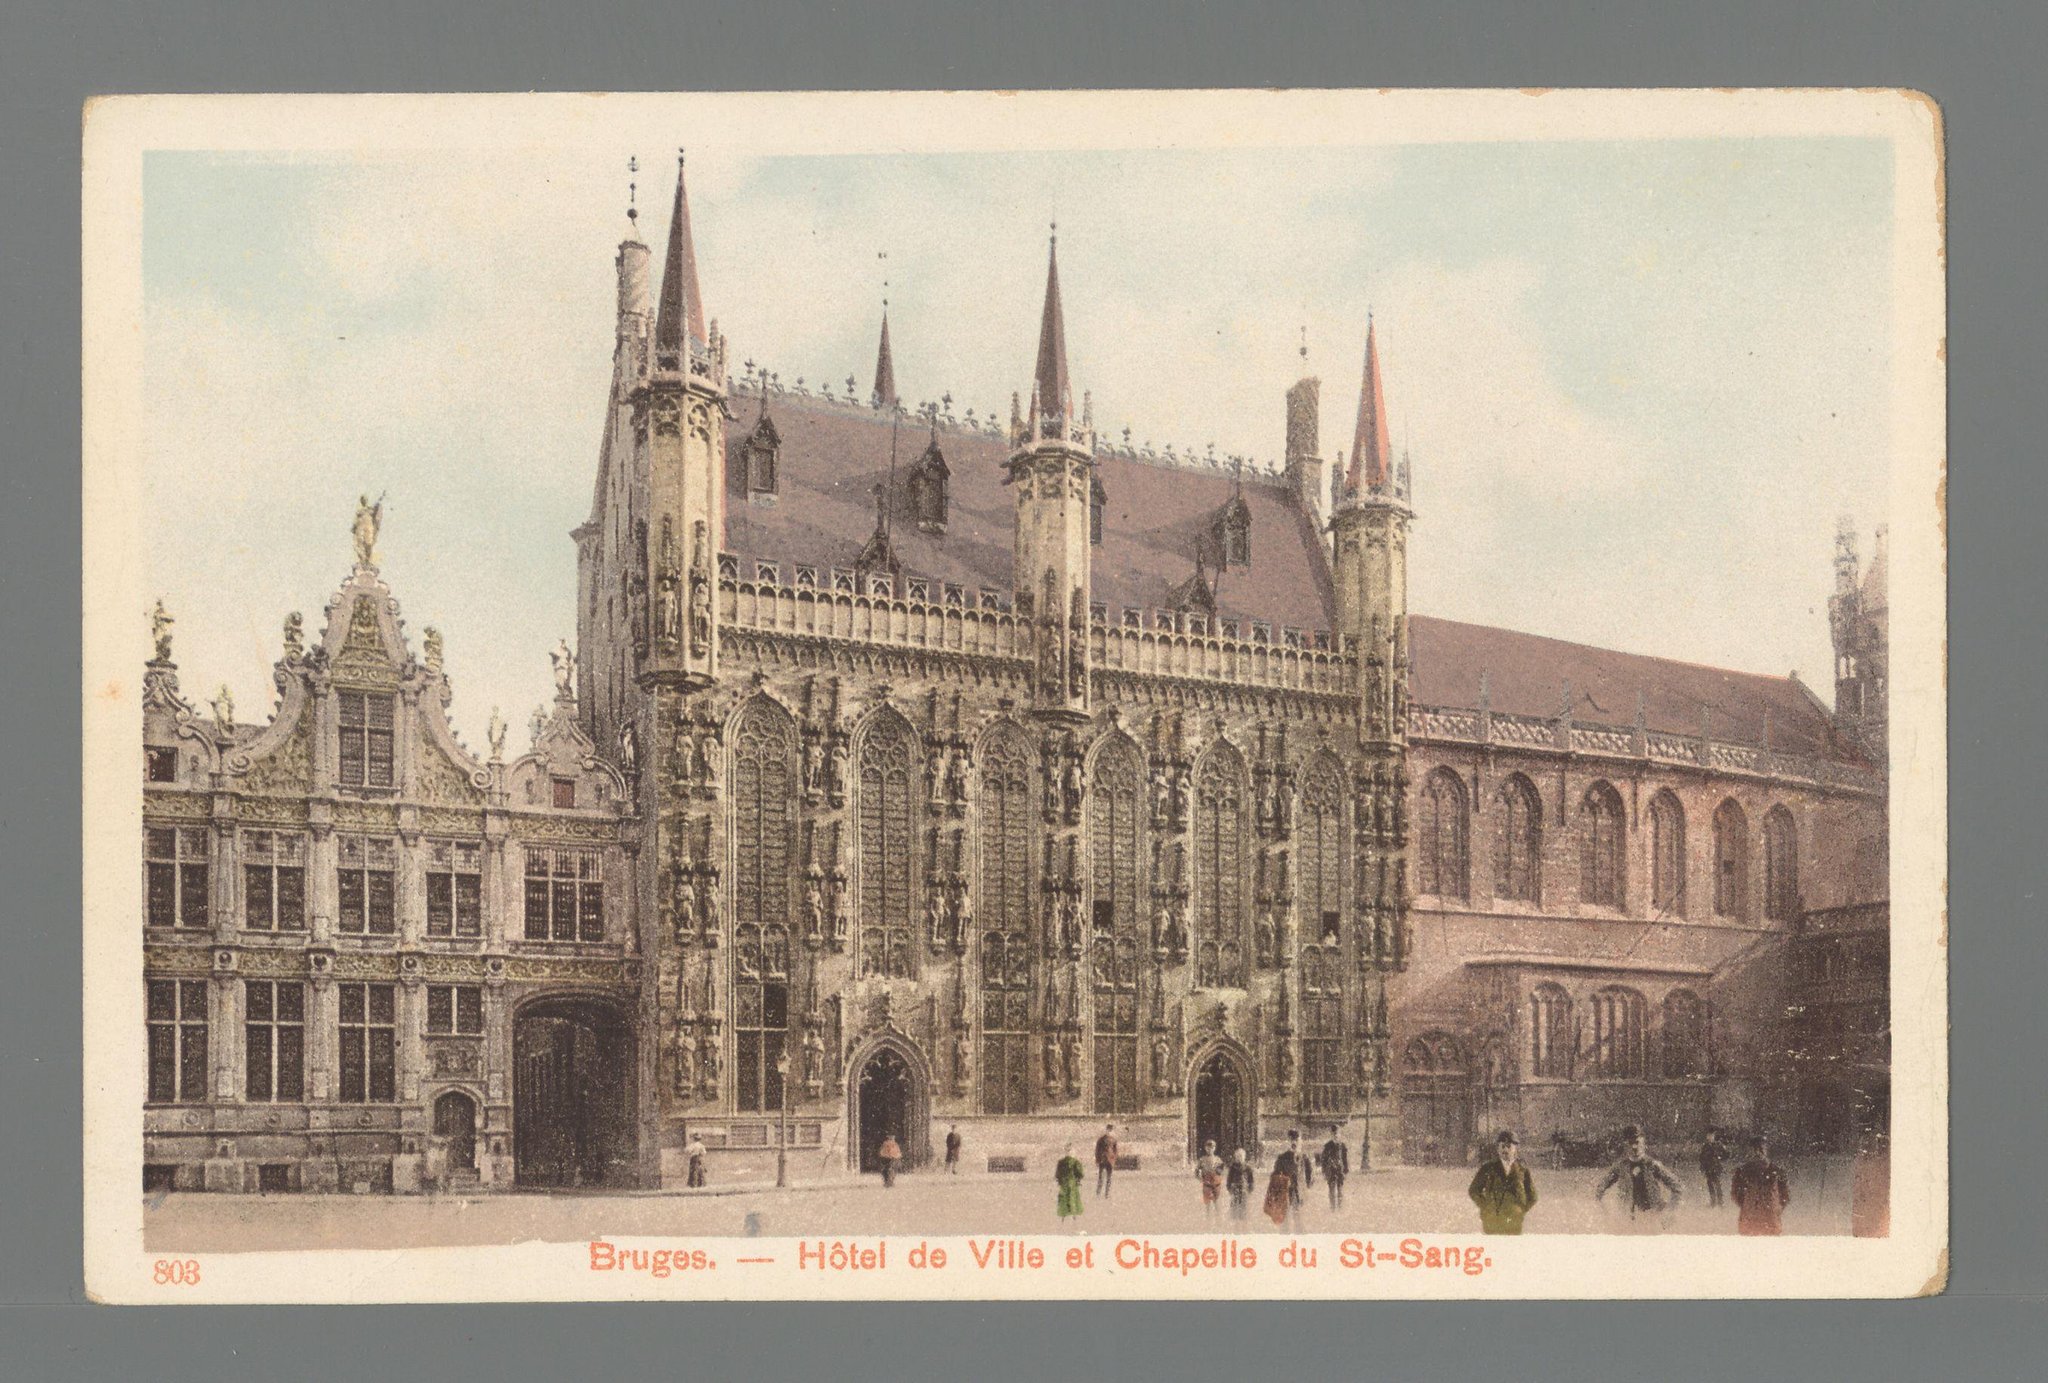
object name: photomechanical print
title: Bruges. Hôtel de Ville et Chapelle du St. Sang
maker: Anonymous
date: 1892-1906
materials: cardboard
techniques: lithograph, photolithography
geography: bruges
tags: townhall, parts of church exterior and annexes, city-view, and landscape with man-made constructions (+ city(-scape) with figures, staffage)